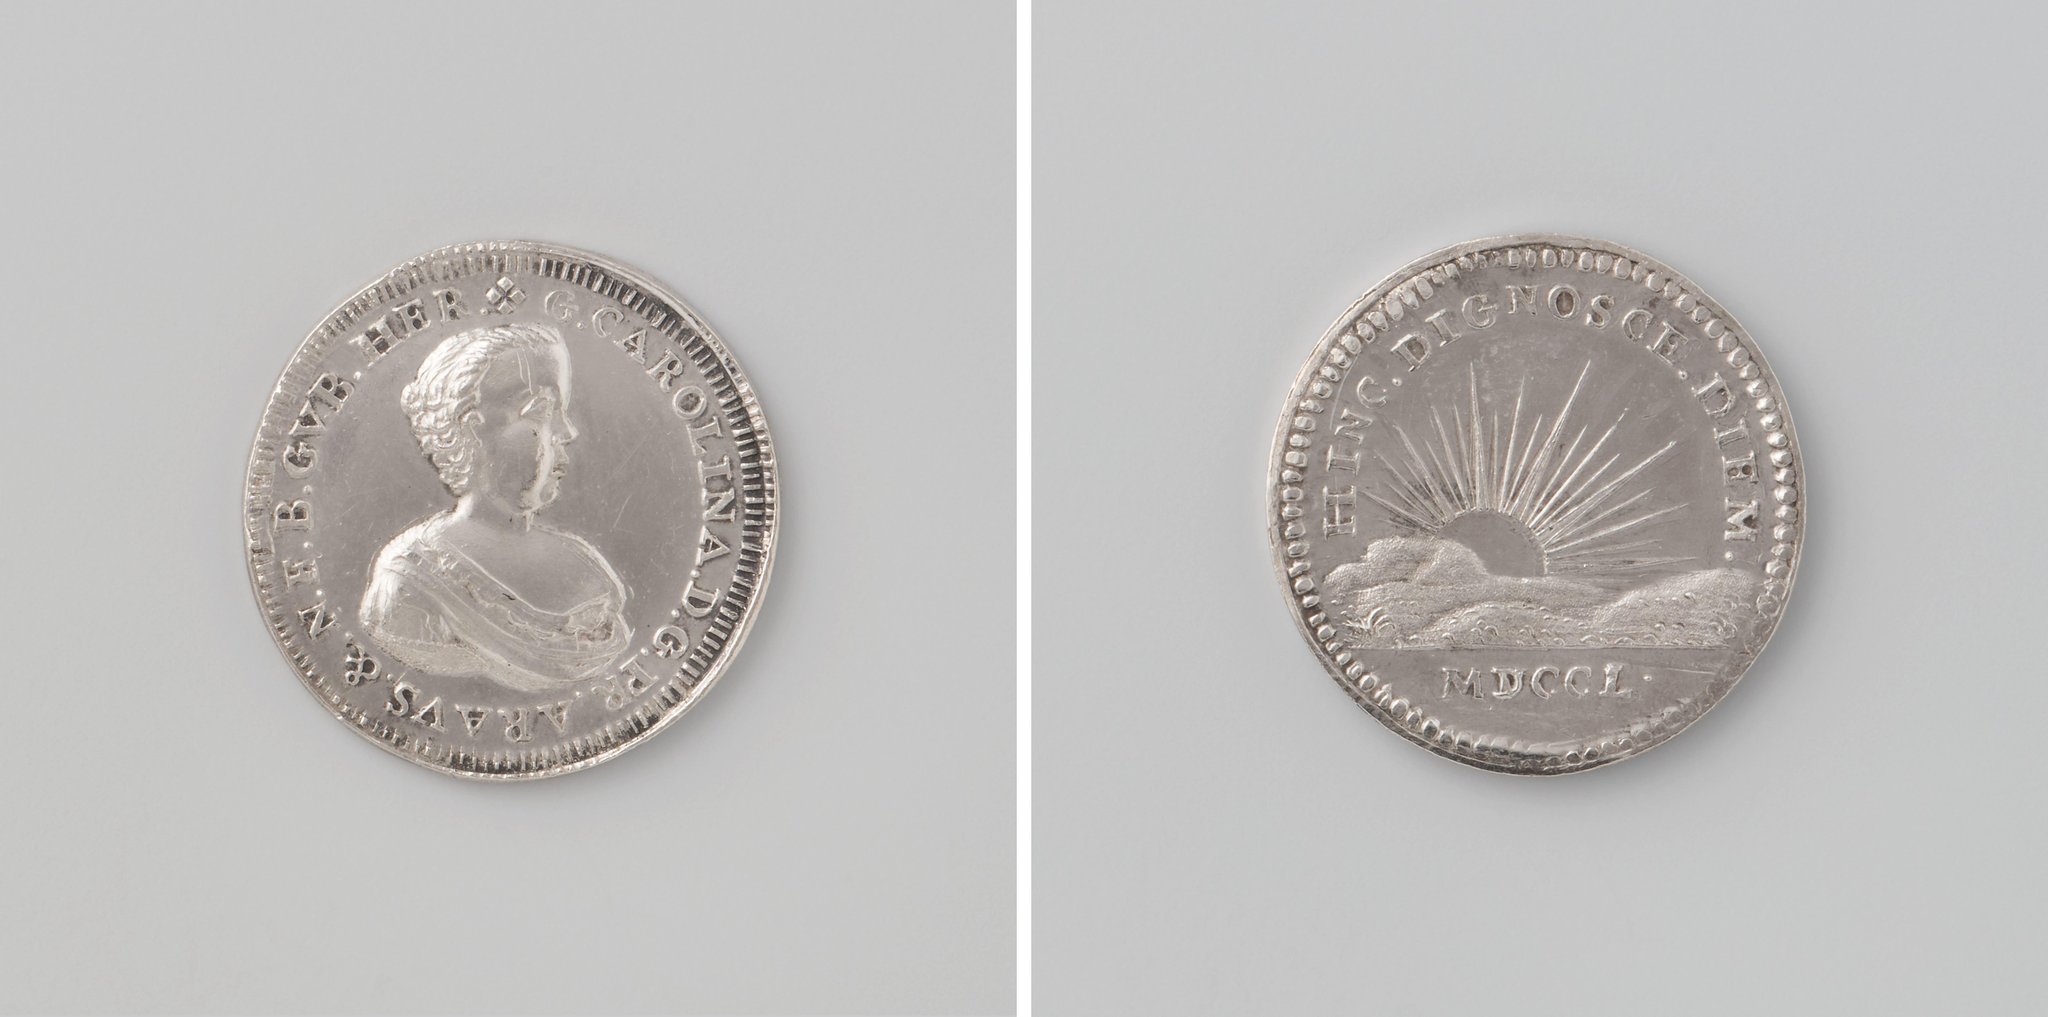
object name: history medal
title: Carolina, prinses van Oranje-Nassau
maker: Anonymous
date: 1750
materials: silver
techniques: striking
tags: carolina (prinses van oranje-nassau)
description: Zilveren penning. Voorzijde: borststuk vrouw binnen omschrift. Keerzijde: opgaande zon binnen omschrift; afsnede: jaartal